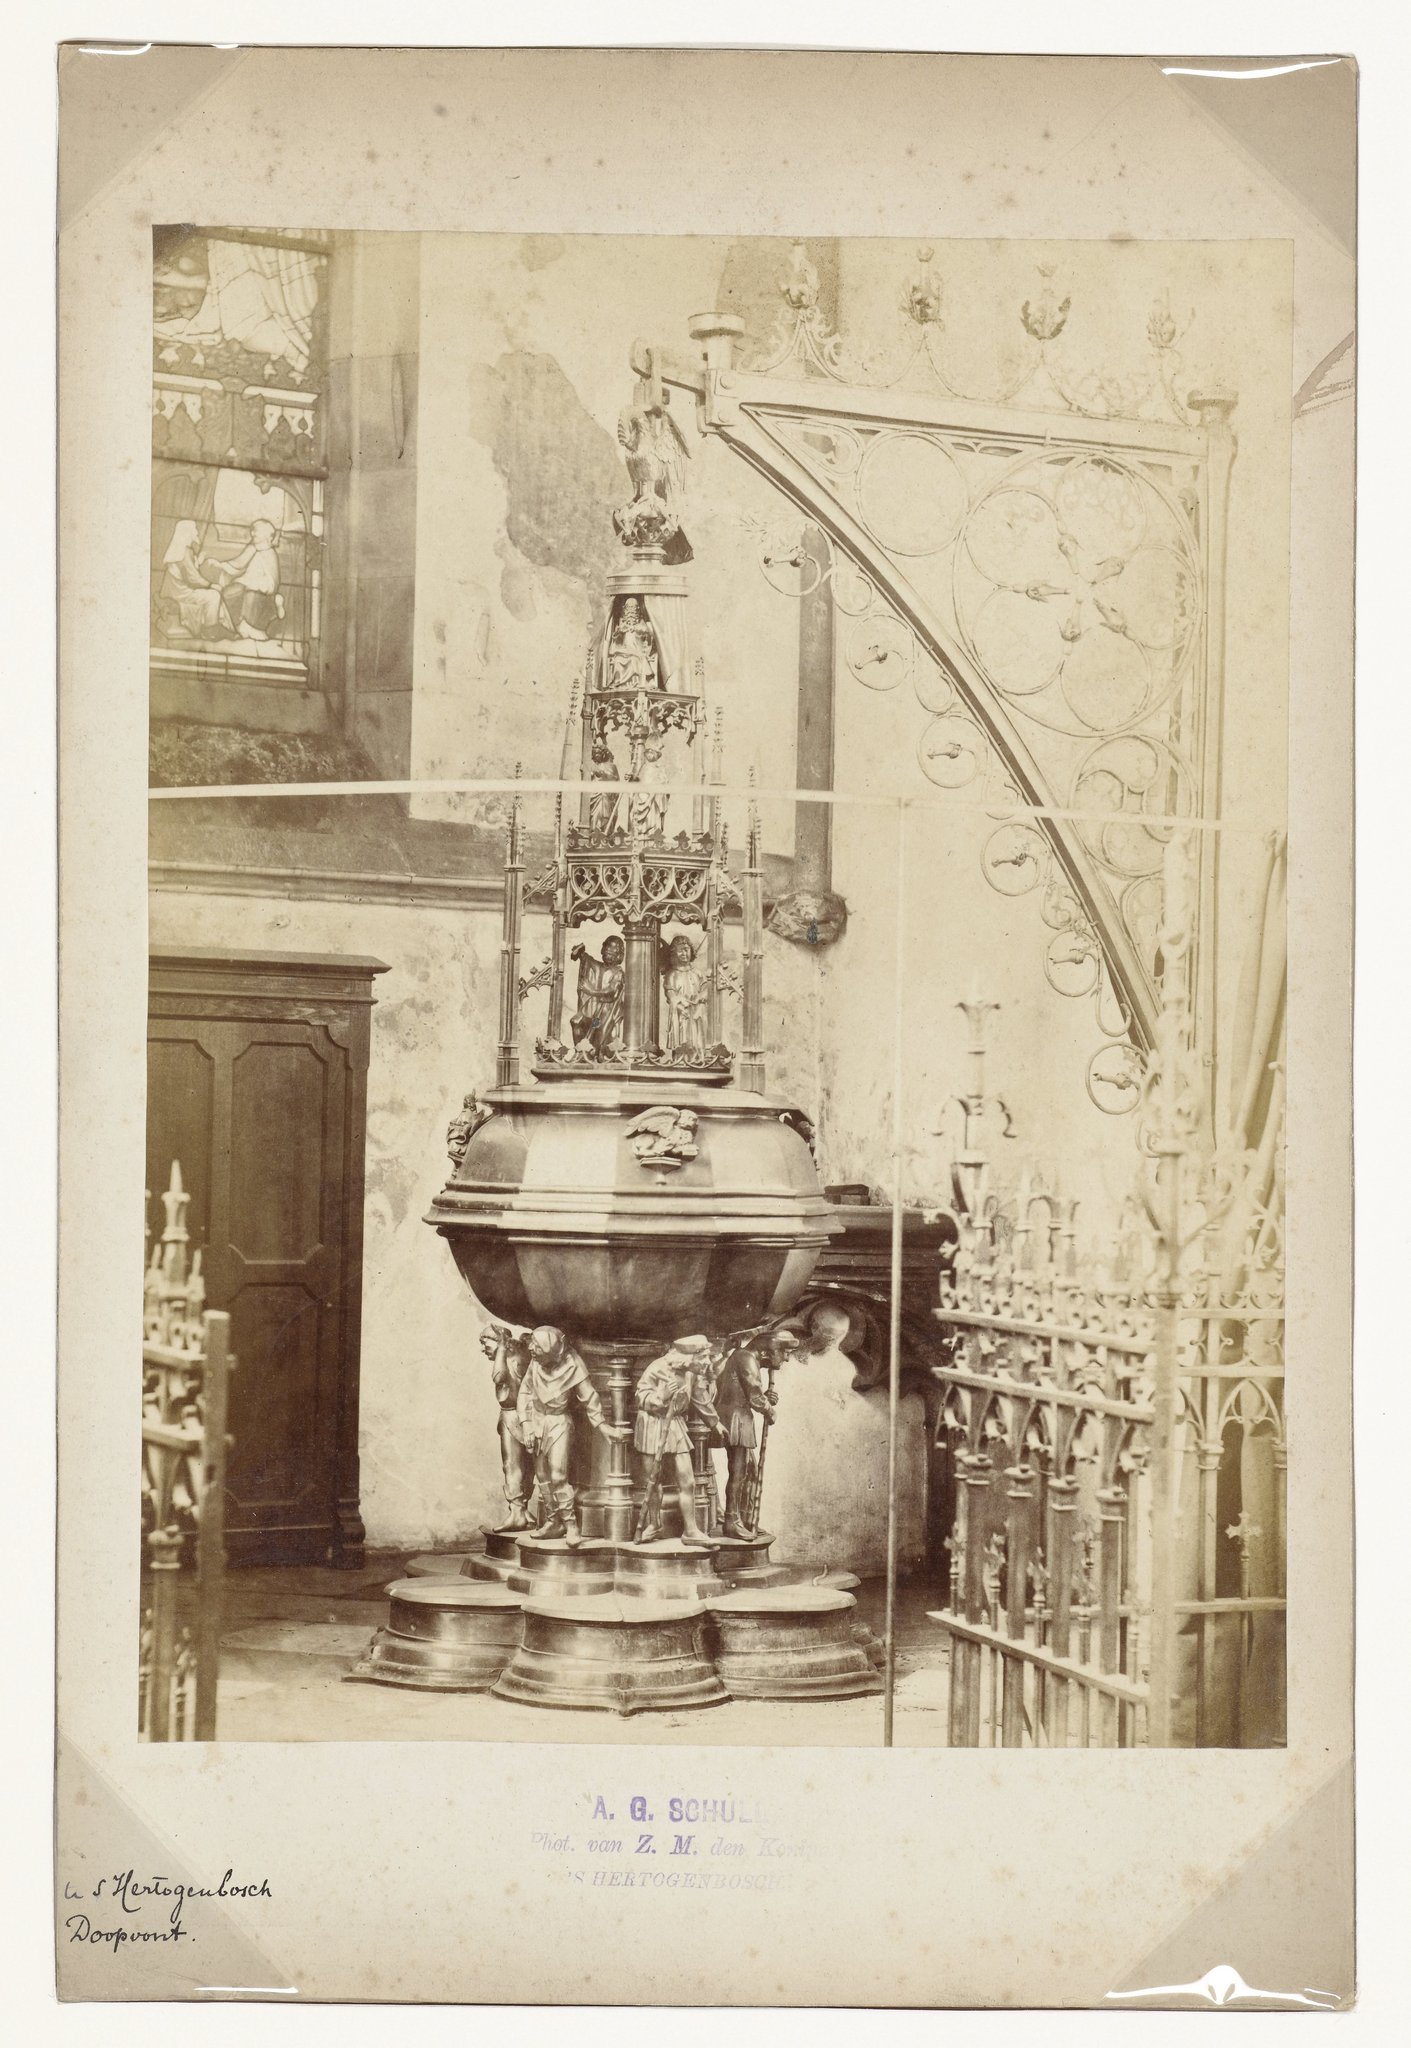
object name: photograph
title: Te 's Hertogenbosch, doopvont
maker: antonius godefridus schull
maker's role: fotograaf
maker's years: 1819-1896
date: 1865-1875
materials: cardboard, paper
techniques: albumen print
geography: den bosch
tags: baptismal font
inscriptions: stamp: ‘A.G. Schull phot van Z.M. den Koning 's Hertogenbosch’